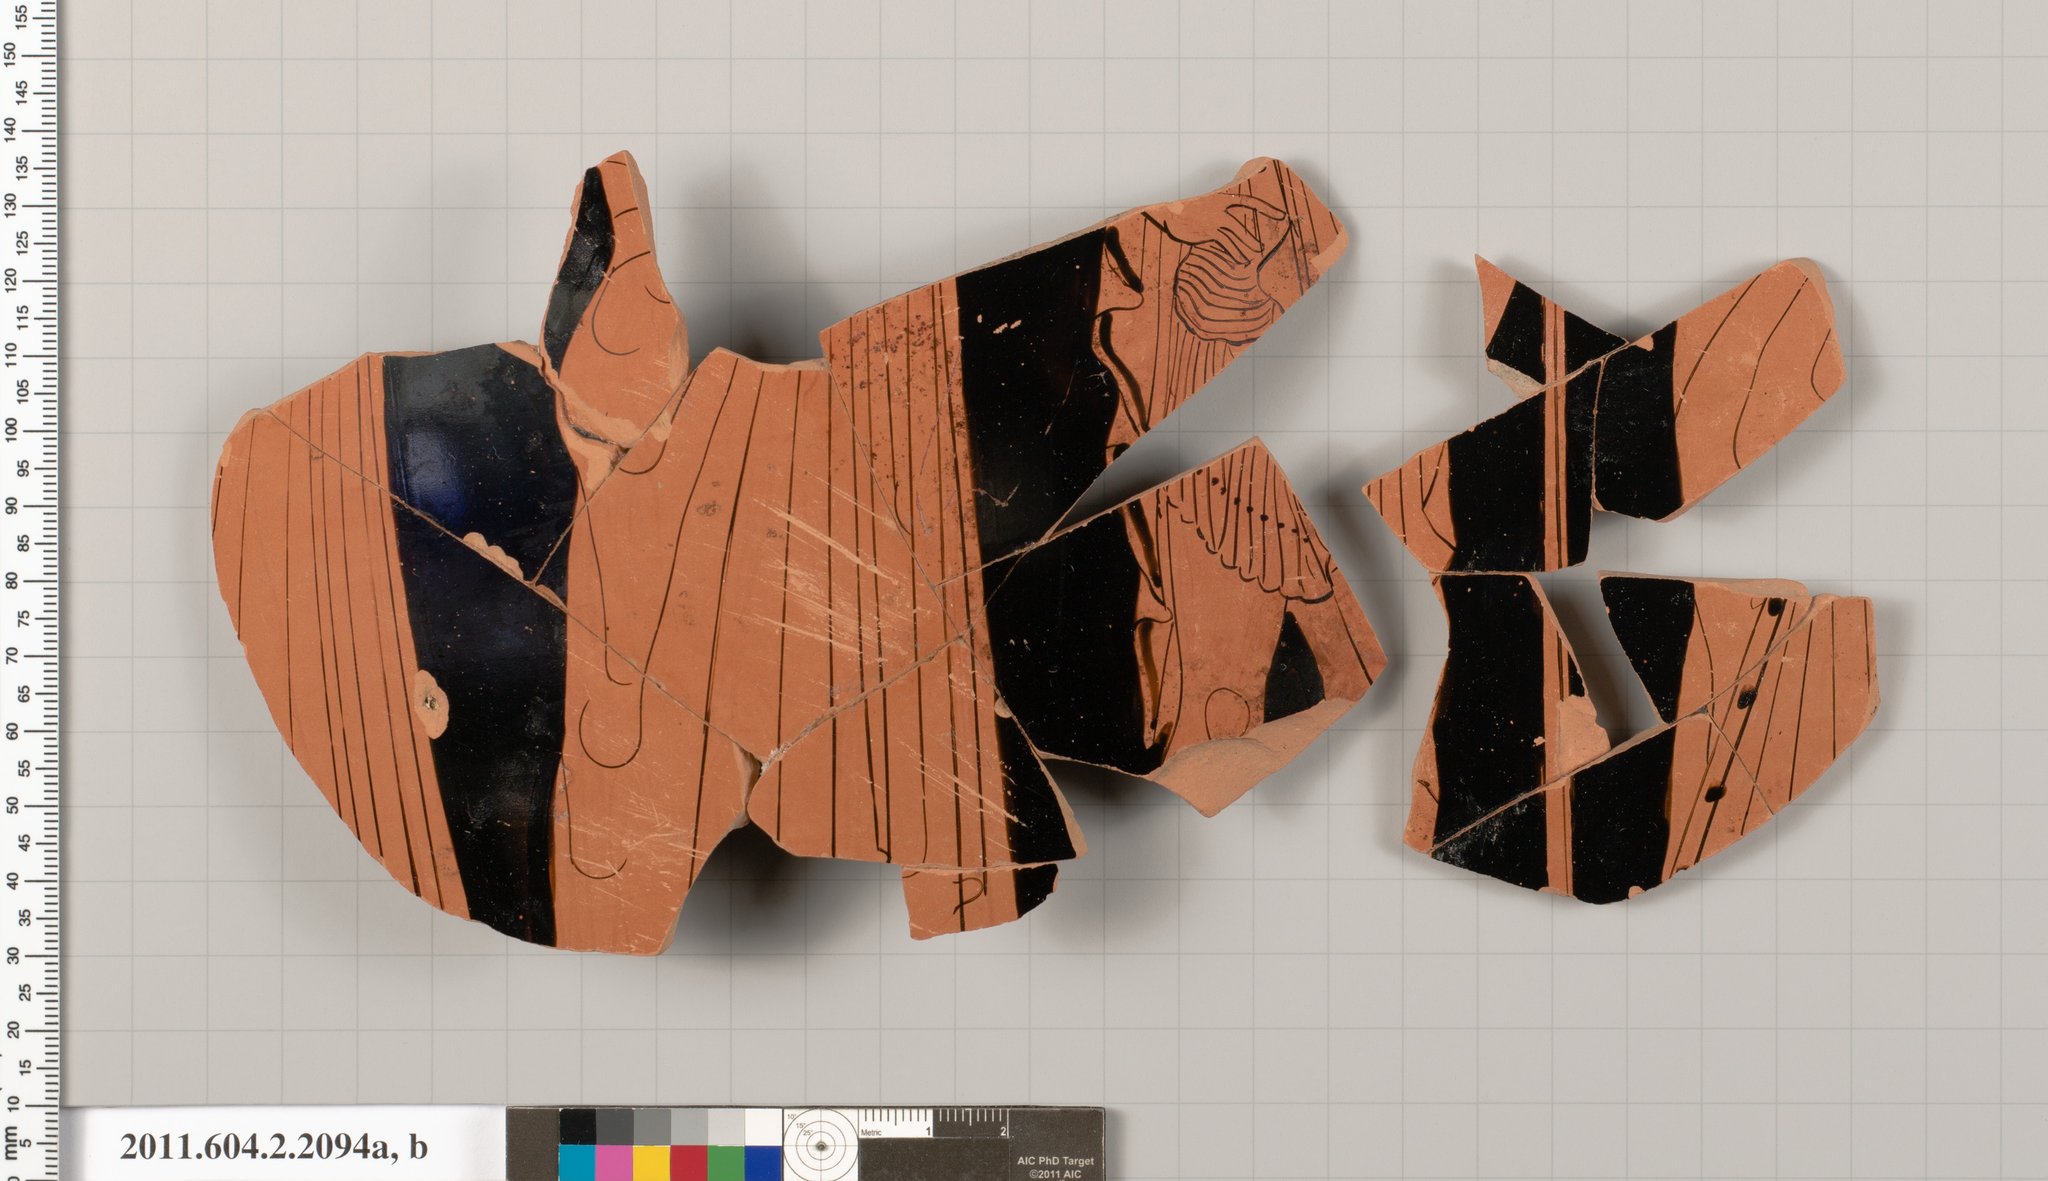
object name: neck amphora fragment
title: Terracotta fragments of a neck-amphora (jar)?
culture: greek, attic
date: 475-451 BCE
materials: terracotta